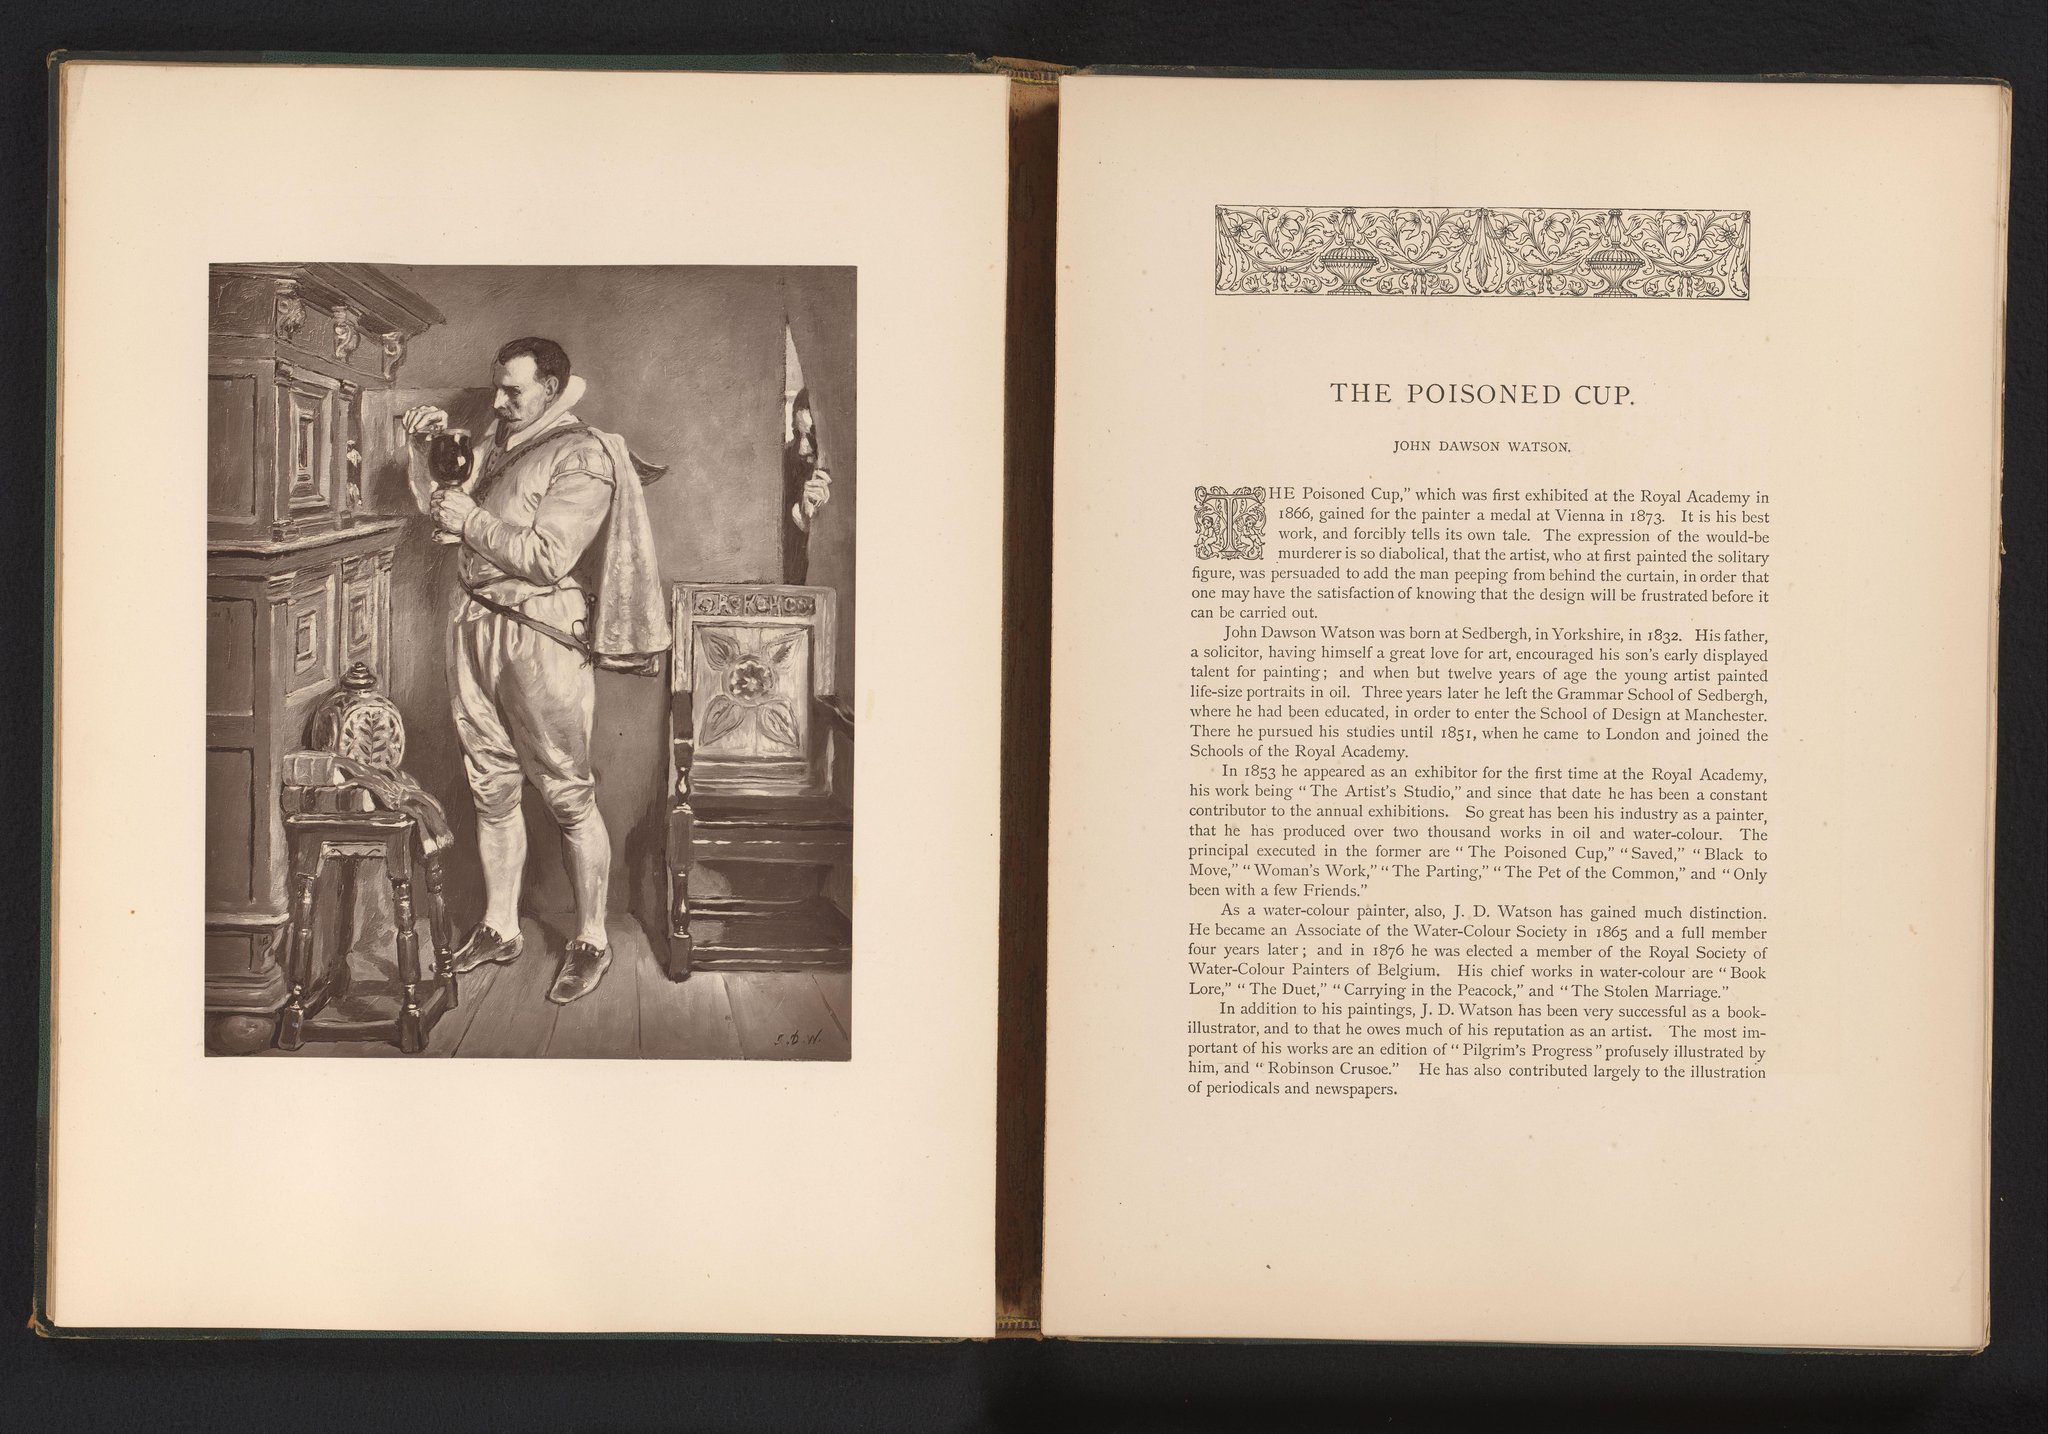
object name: reproduction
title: Reproductie van een schilderij van The poison cup door John Dawson Watson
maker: Anonymous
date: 1874-1879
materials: paper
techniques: woodburytype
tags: poisoner, cup